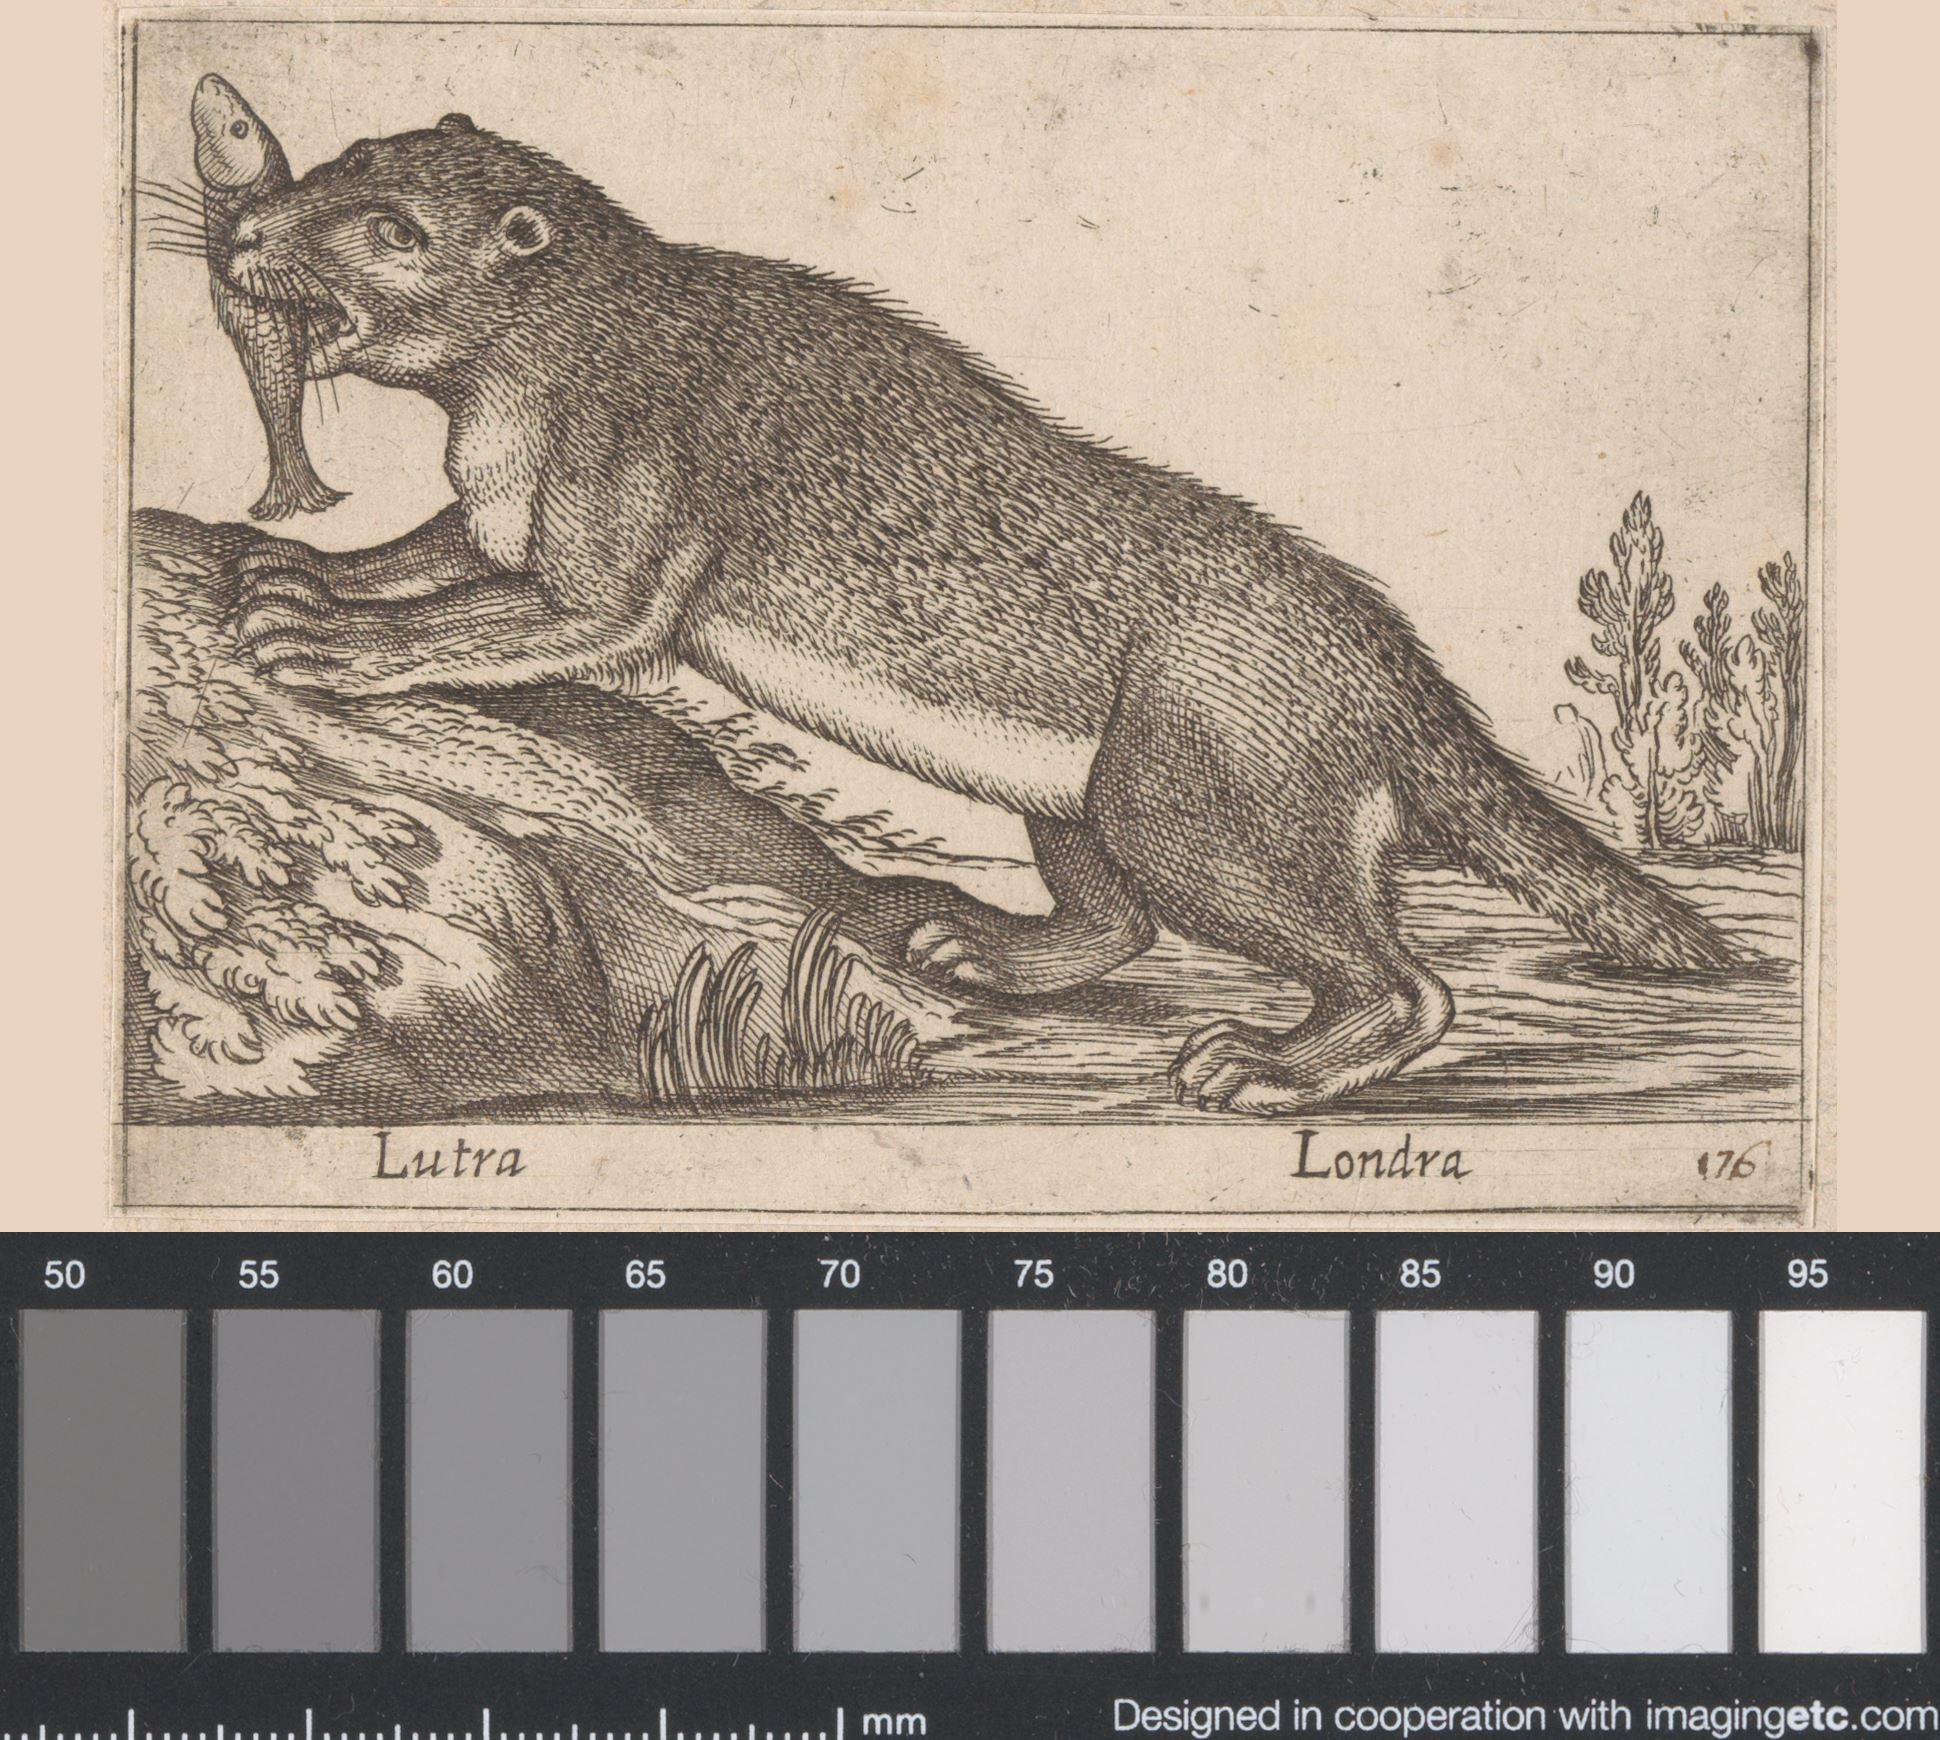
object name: print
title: Nova raccolta de li animali piu curiosi del mondo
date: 1565-1630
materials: paper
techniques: etching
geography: vatican city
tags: beasts of prey, predatory animals: otter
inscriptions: number: ‘176’, collector's mark: Lugt 11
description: Deze prent maakt deel uit van een reeks prenten van dieren door Antonio Tempesta. Bekend is dat een tweede staat (met nummering) van deze serie is uitgegeven door Giovanni Giacomo de' Rossi in 1650. Onbekend is wie de eerste staat heeft uitgegeven en wanneer.